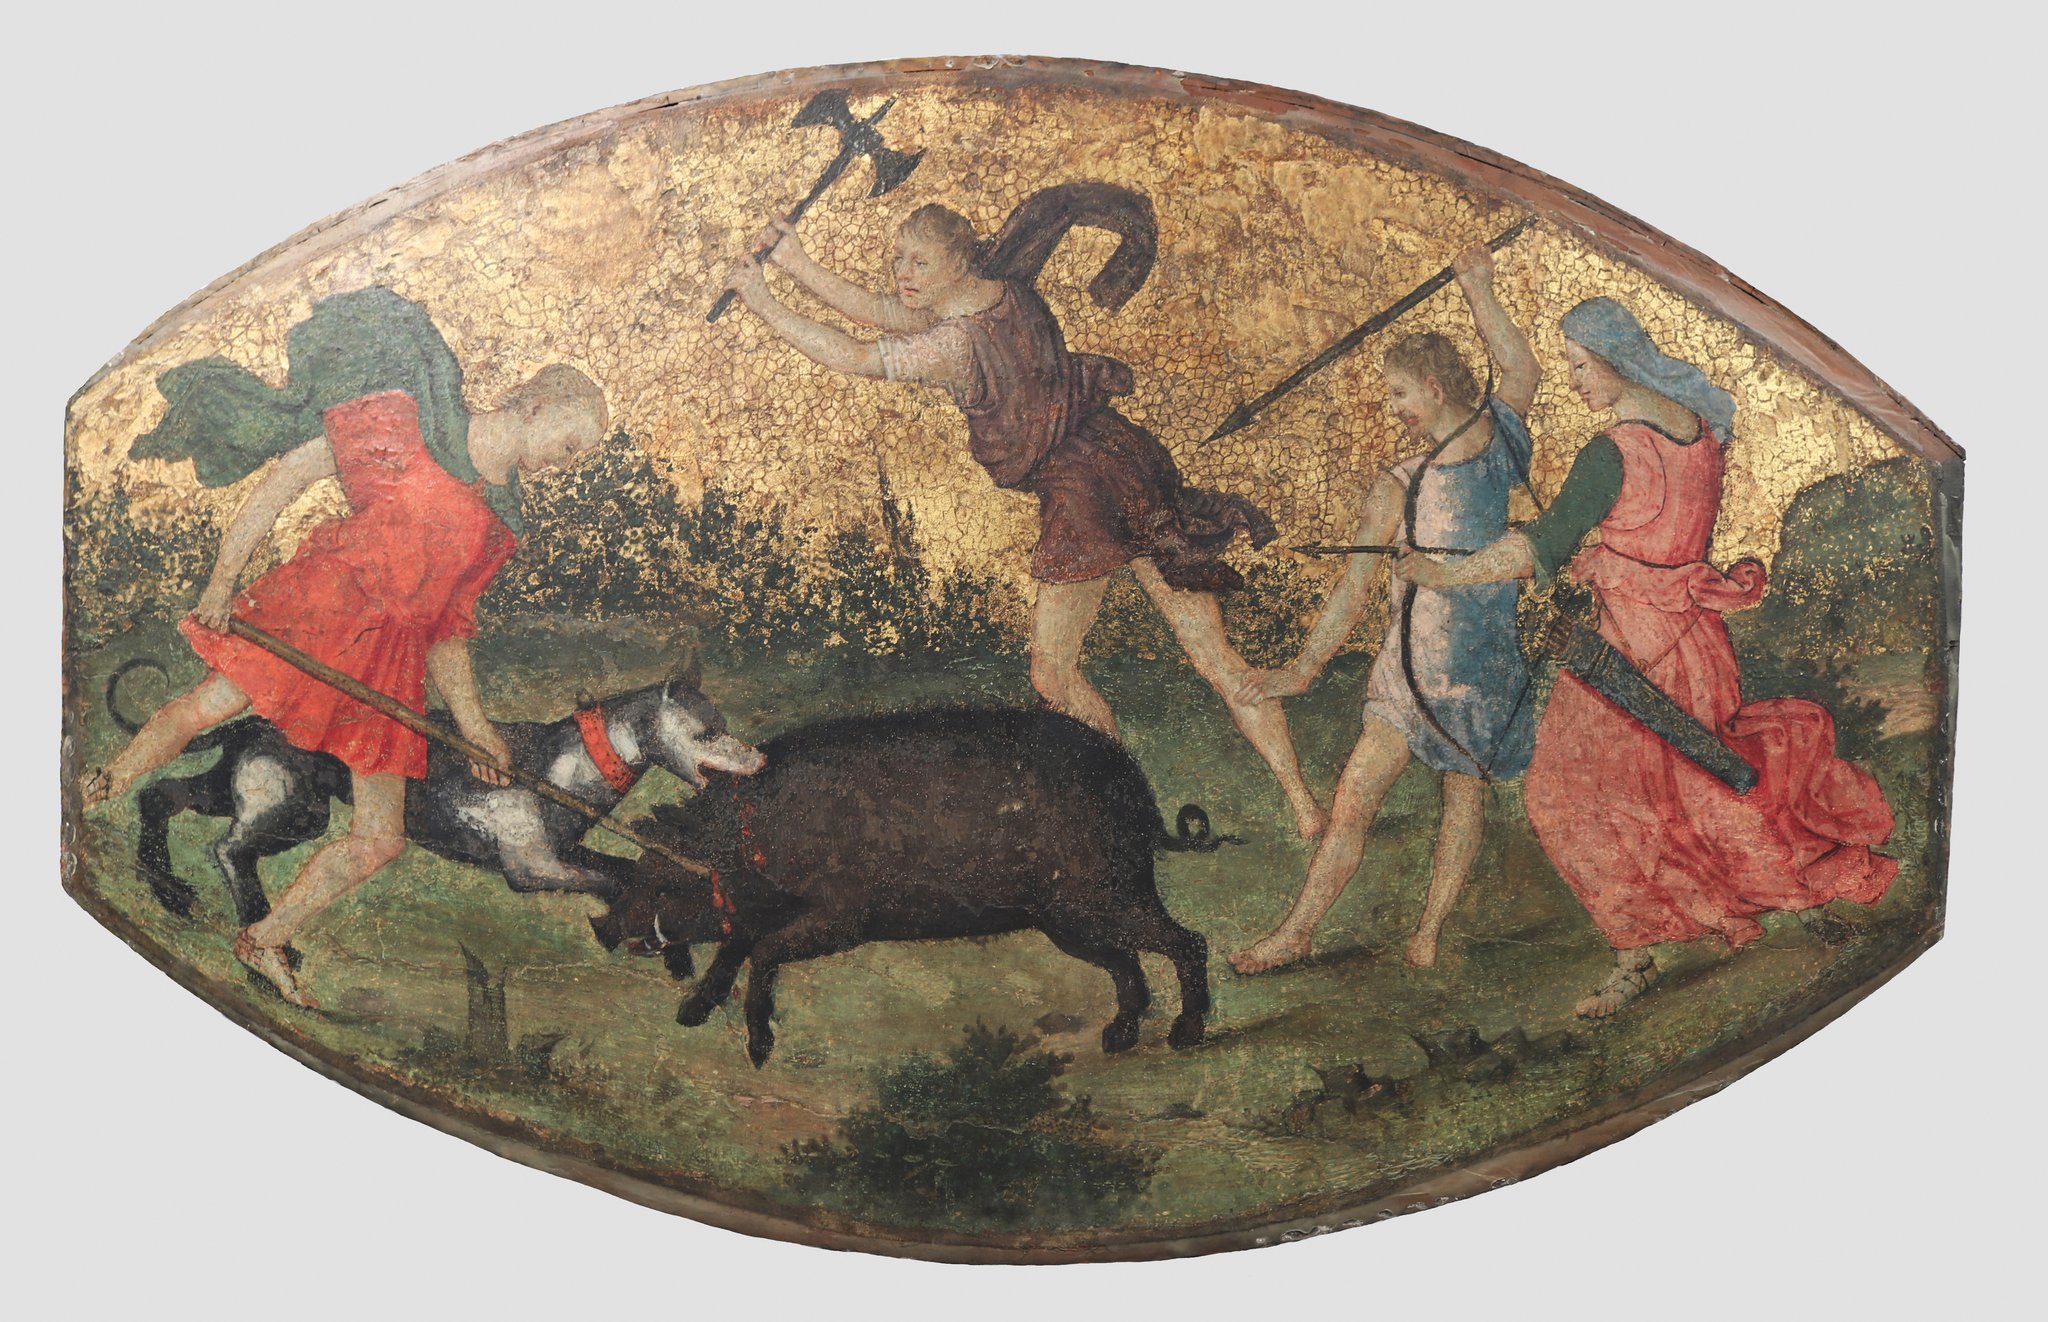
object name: ceiling panel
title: Hunt of the Calydonian Boar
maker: pinturicchio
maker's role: artist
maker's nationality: italian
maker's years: 1454-1513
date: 1509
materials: canvas, panel, wood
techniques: fresco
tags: men,hunting,boars,dogs